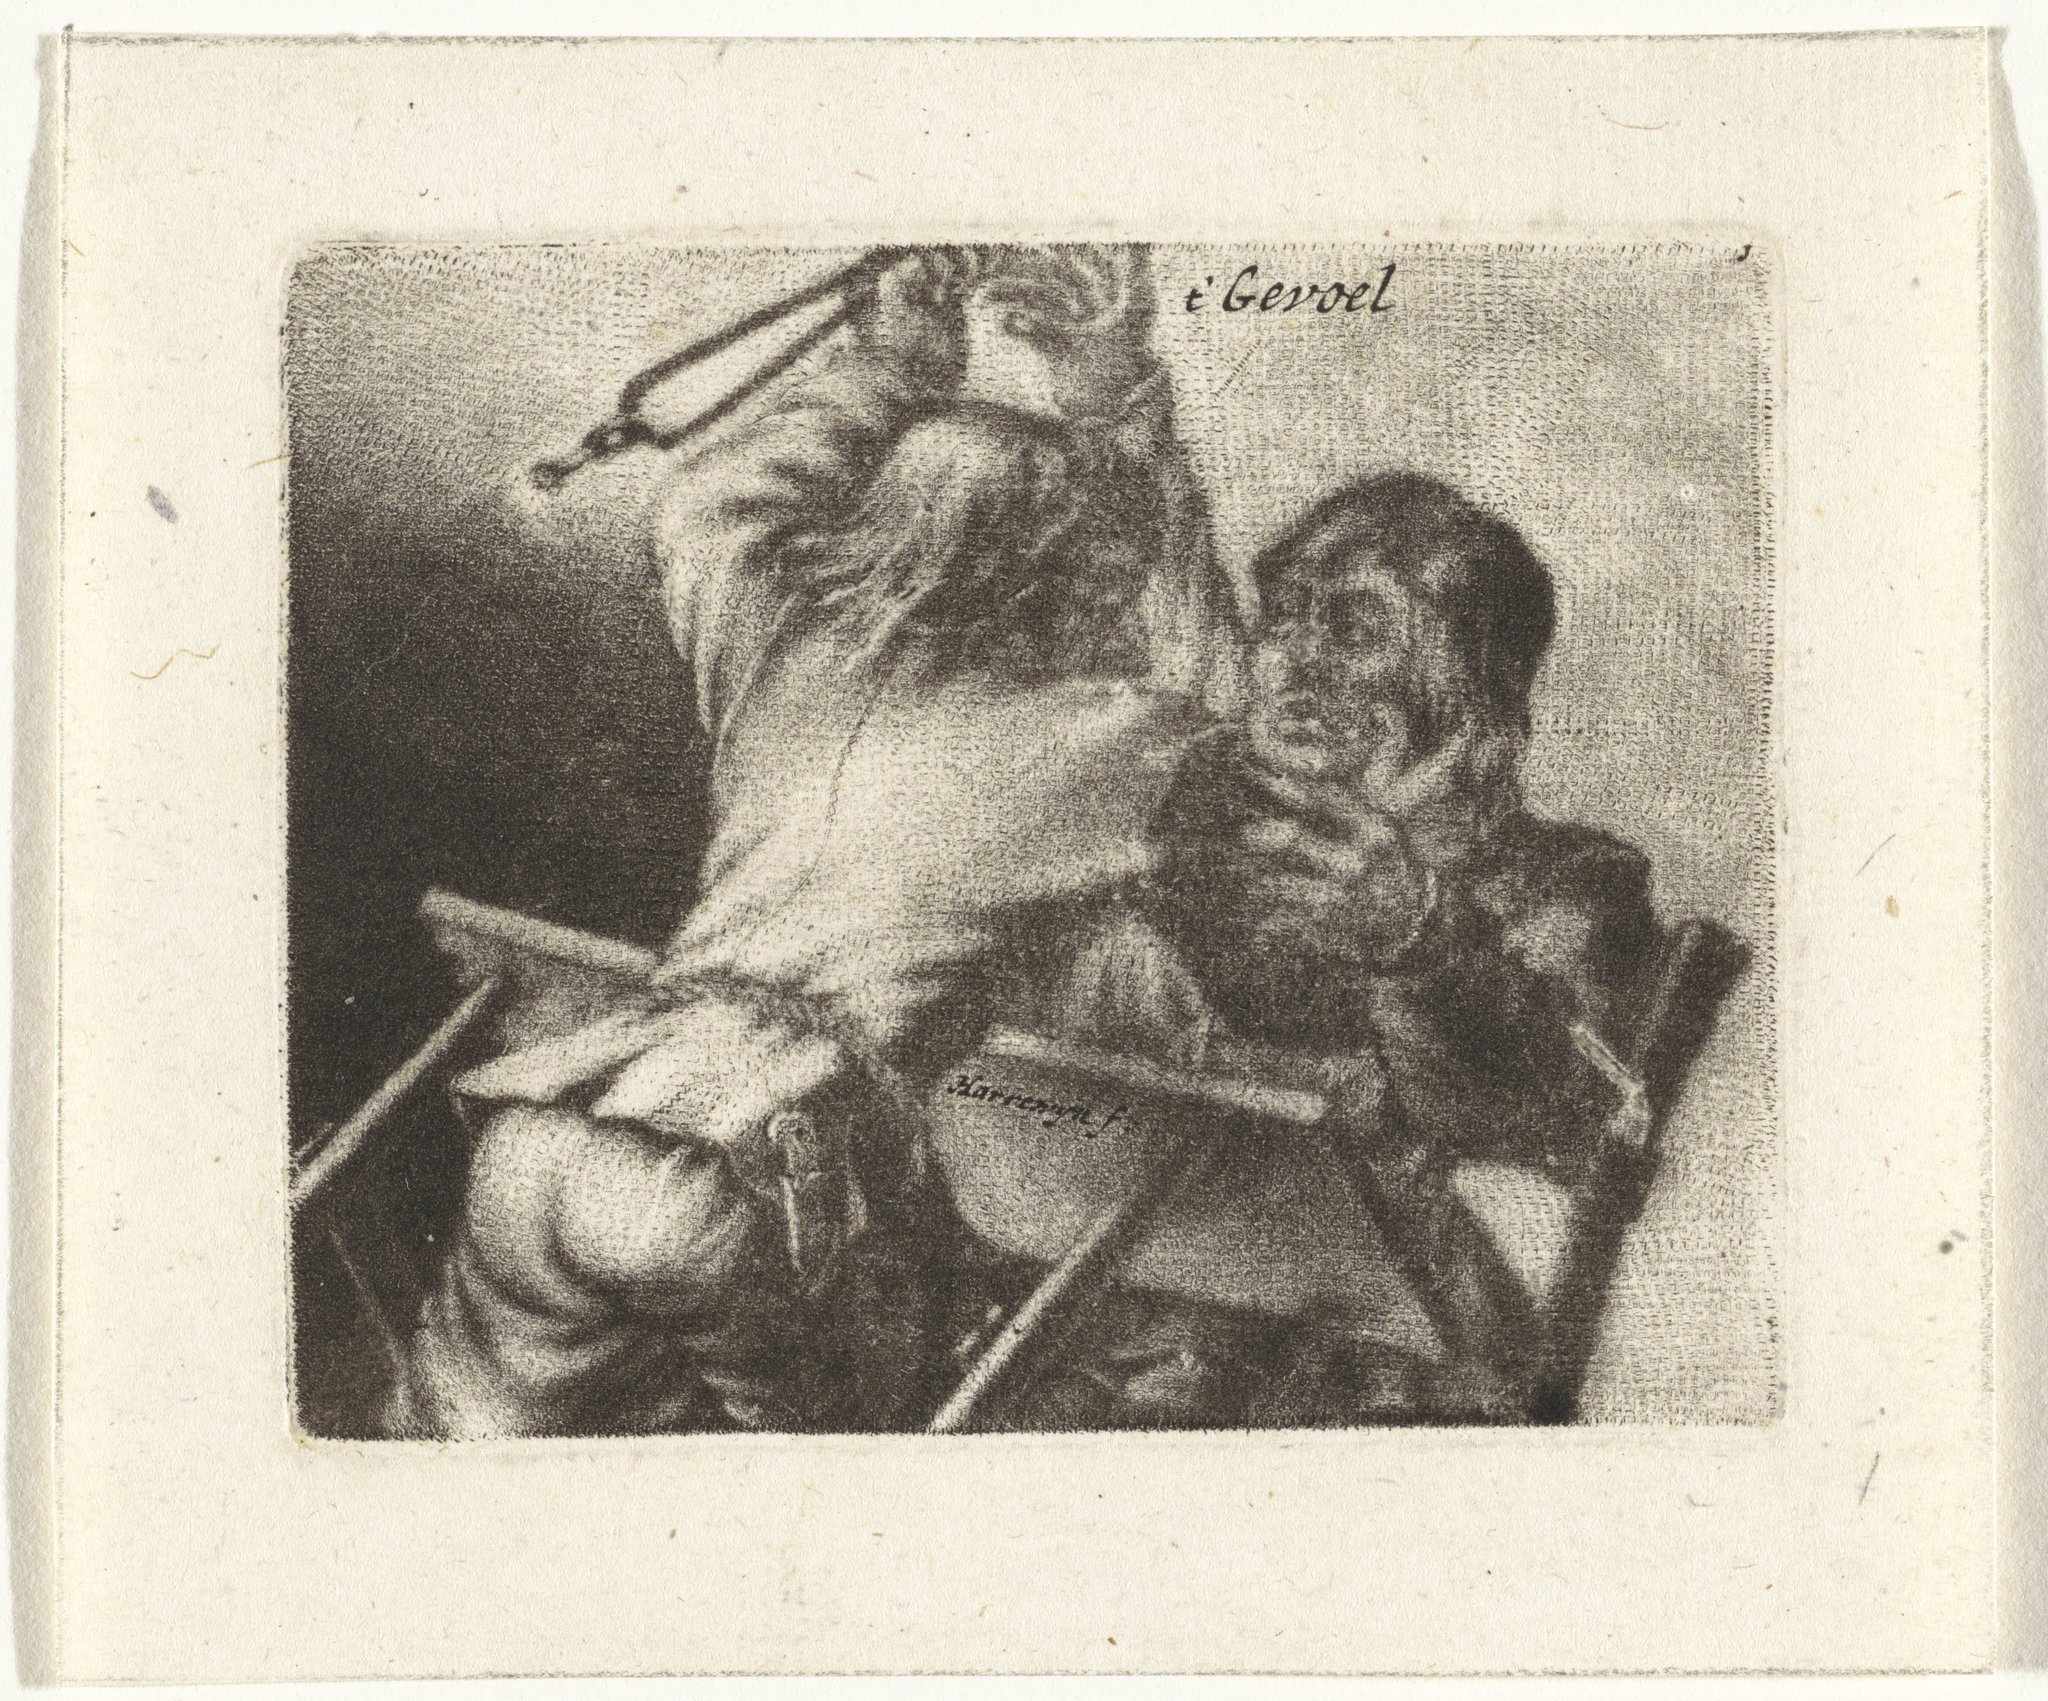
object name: print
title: Vechtende mannen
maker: jacobus harrewijn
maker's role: print maker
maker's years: 1660-1740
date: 1690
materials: paper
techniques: engraving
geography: southern netherlands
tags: feeling (one of the five senses), fighting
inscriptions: collector's mark: Lugt 2228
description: Het Gevoel. Twee mannen zijn met elkaar in gevecht. De prent maakt deel uit van een serie van vijf prenten met de vijf zintuigen.